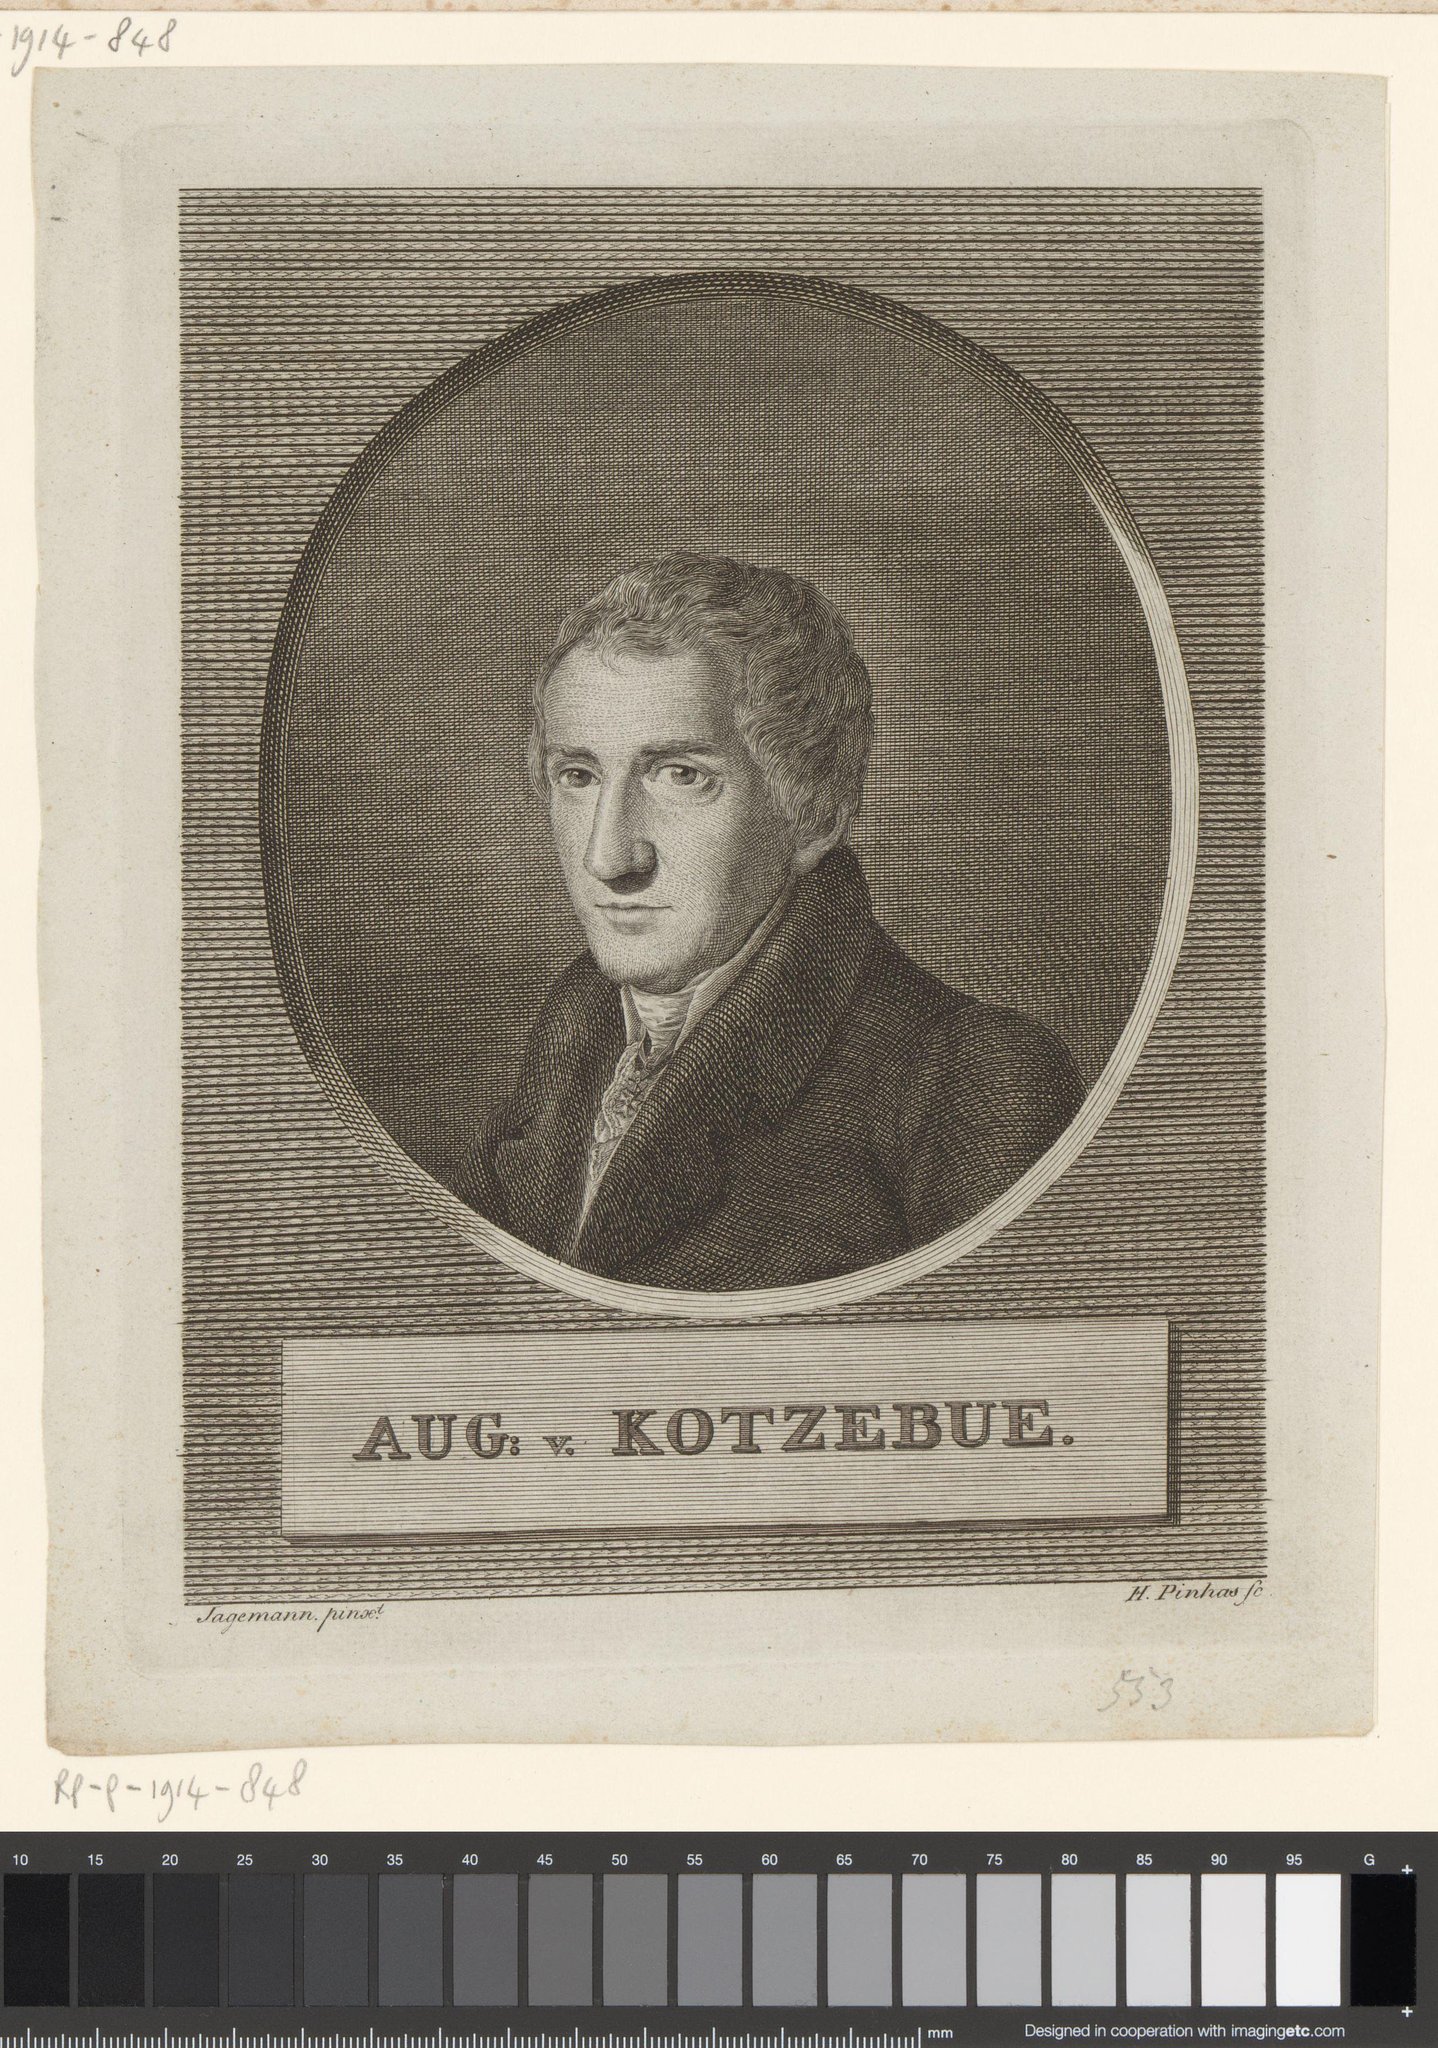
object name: print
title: Portret van August Friedrich Ferdinand von Kotzebue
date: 1805-1844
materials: paper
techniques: engraving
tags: historical persons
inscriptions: number: ‘53'3’, collector's mark: Lugt 2228